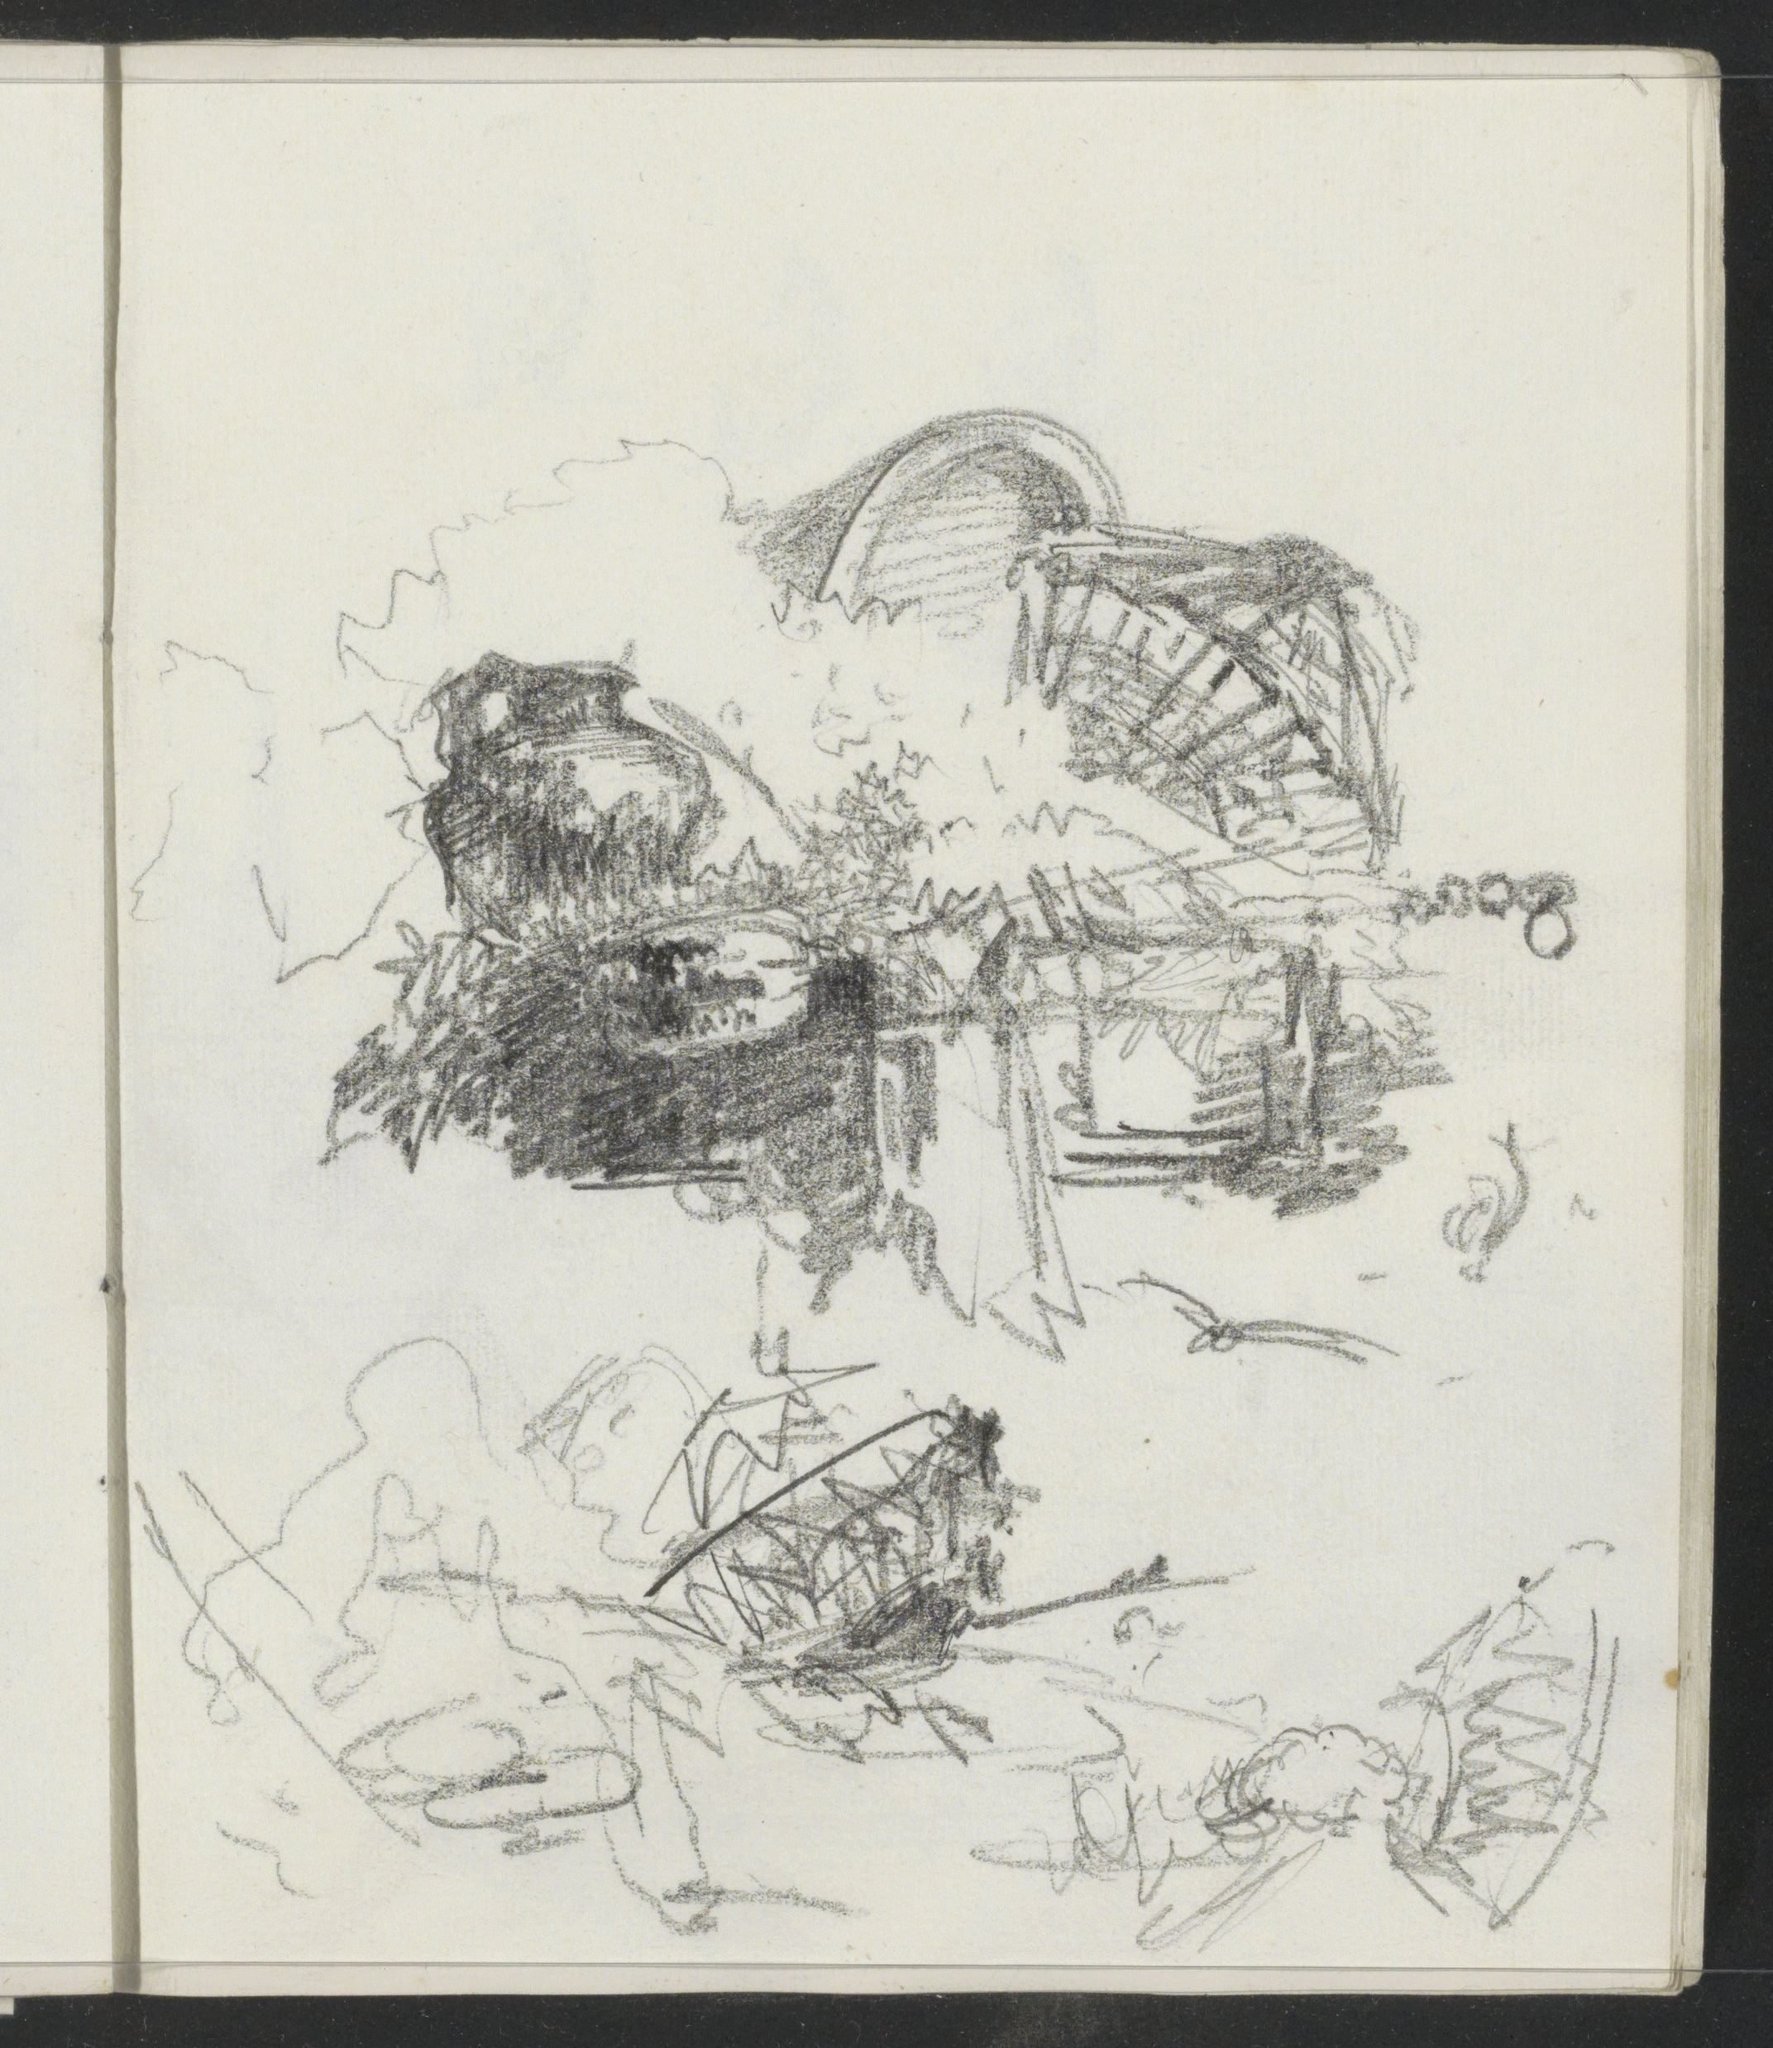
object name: sketchbook leaf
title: Studies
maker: maria vos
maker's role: draughtsman, painter, print maker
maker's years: 1824-1906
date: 1834-1906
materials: paper, pencil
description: Blad 13 recto uit een schetsboek met 20 bladen.